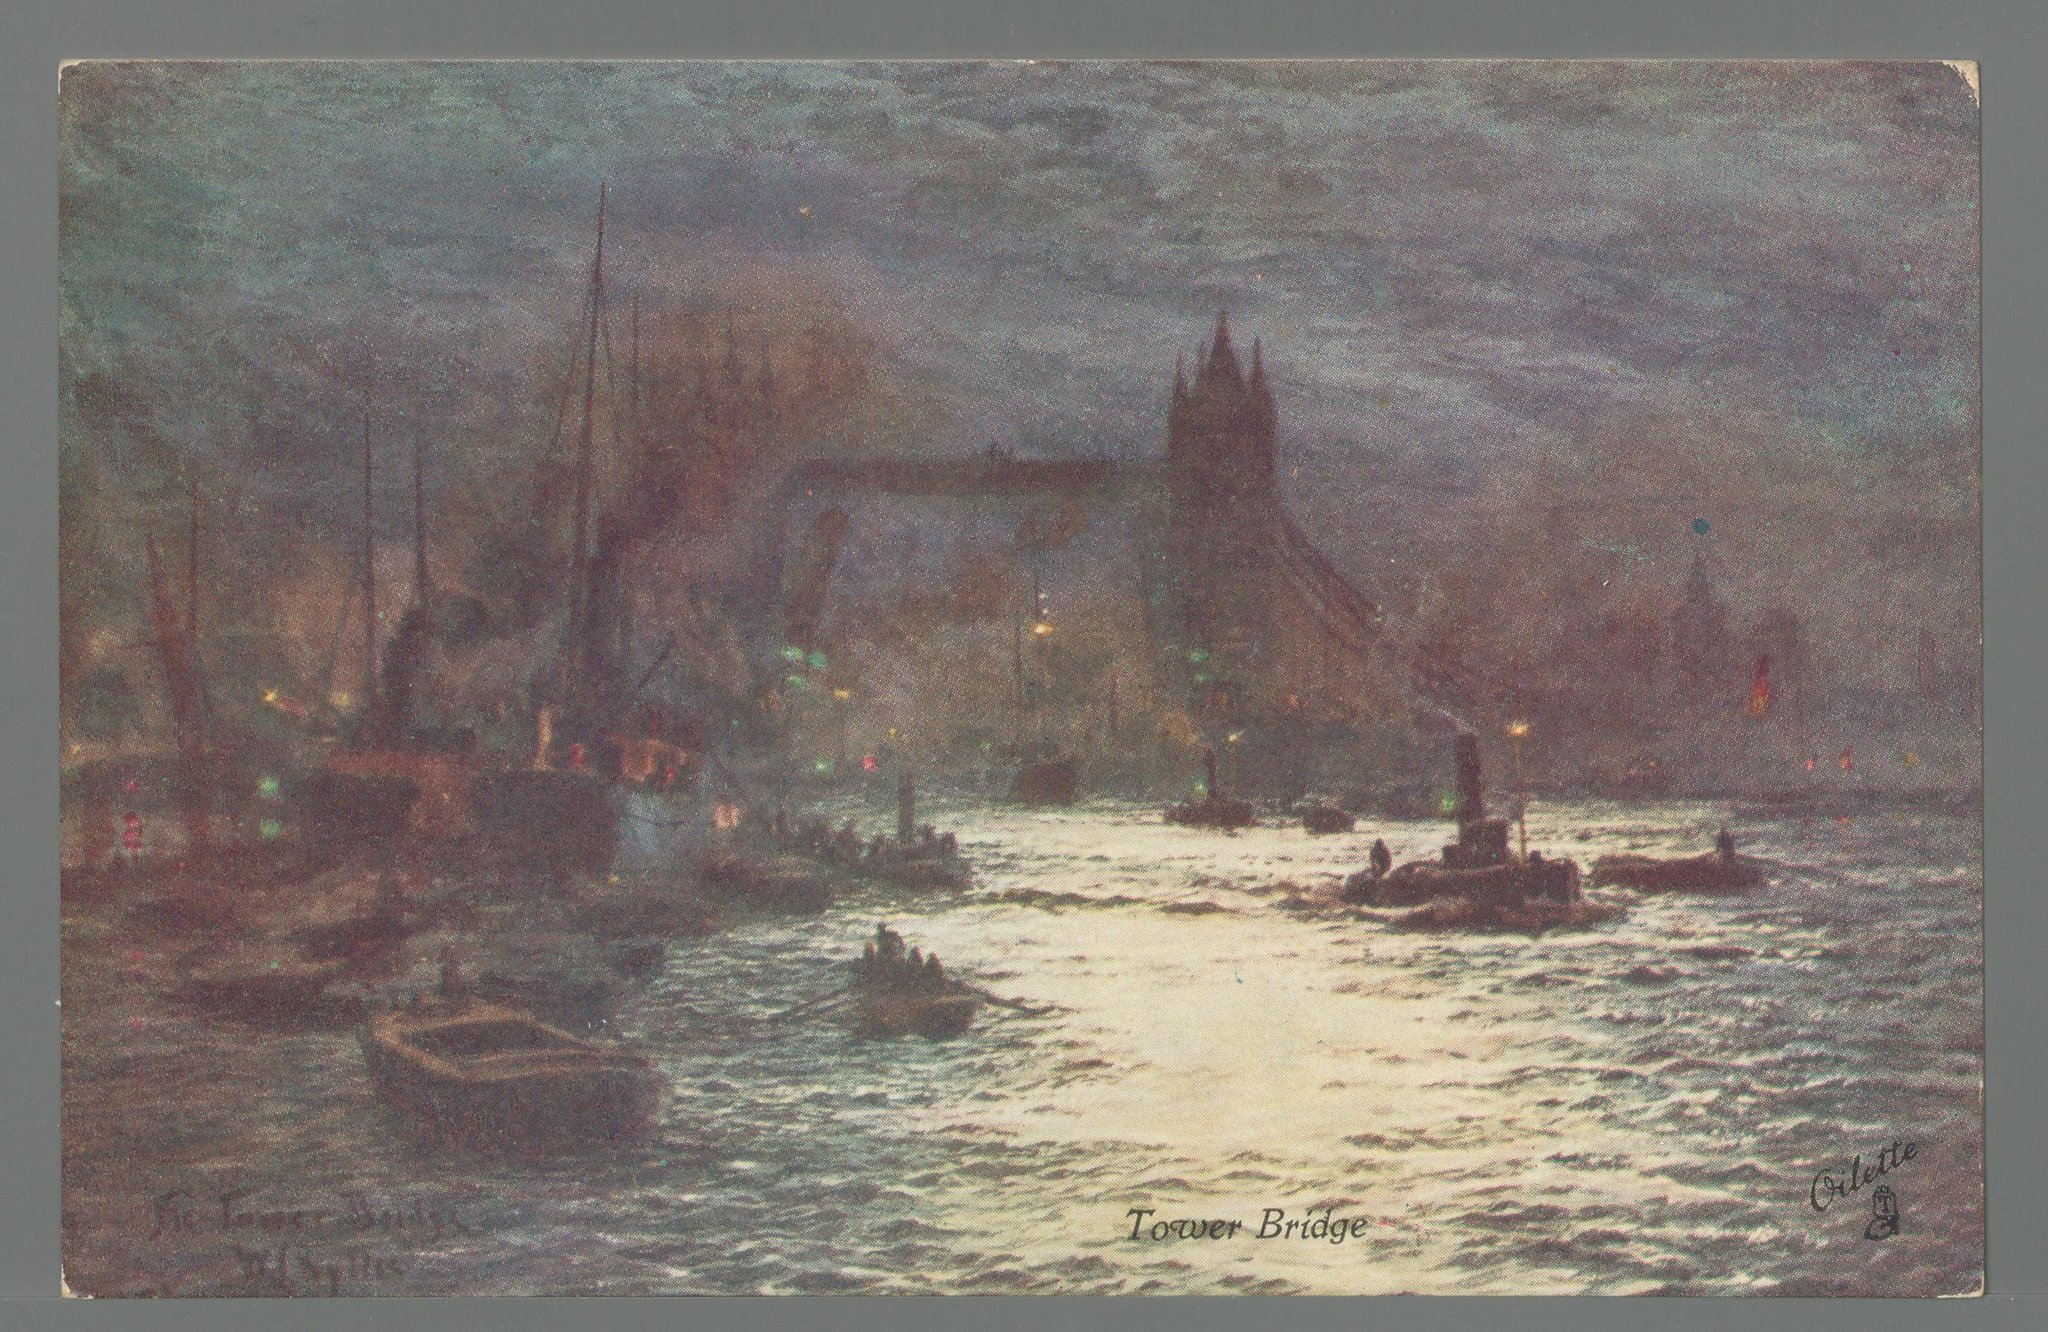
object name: ansichtkaart, prentbriefkaart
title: Tower Bridge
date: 1907-1909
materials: cardboard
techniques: writing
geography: london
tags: ships (in general), canals, waters (in city), bridge in city across river, canal, etc., thames